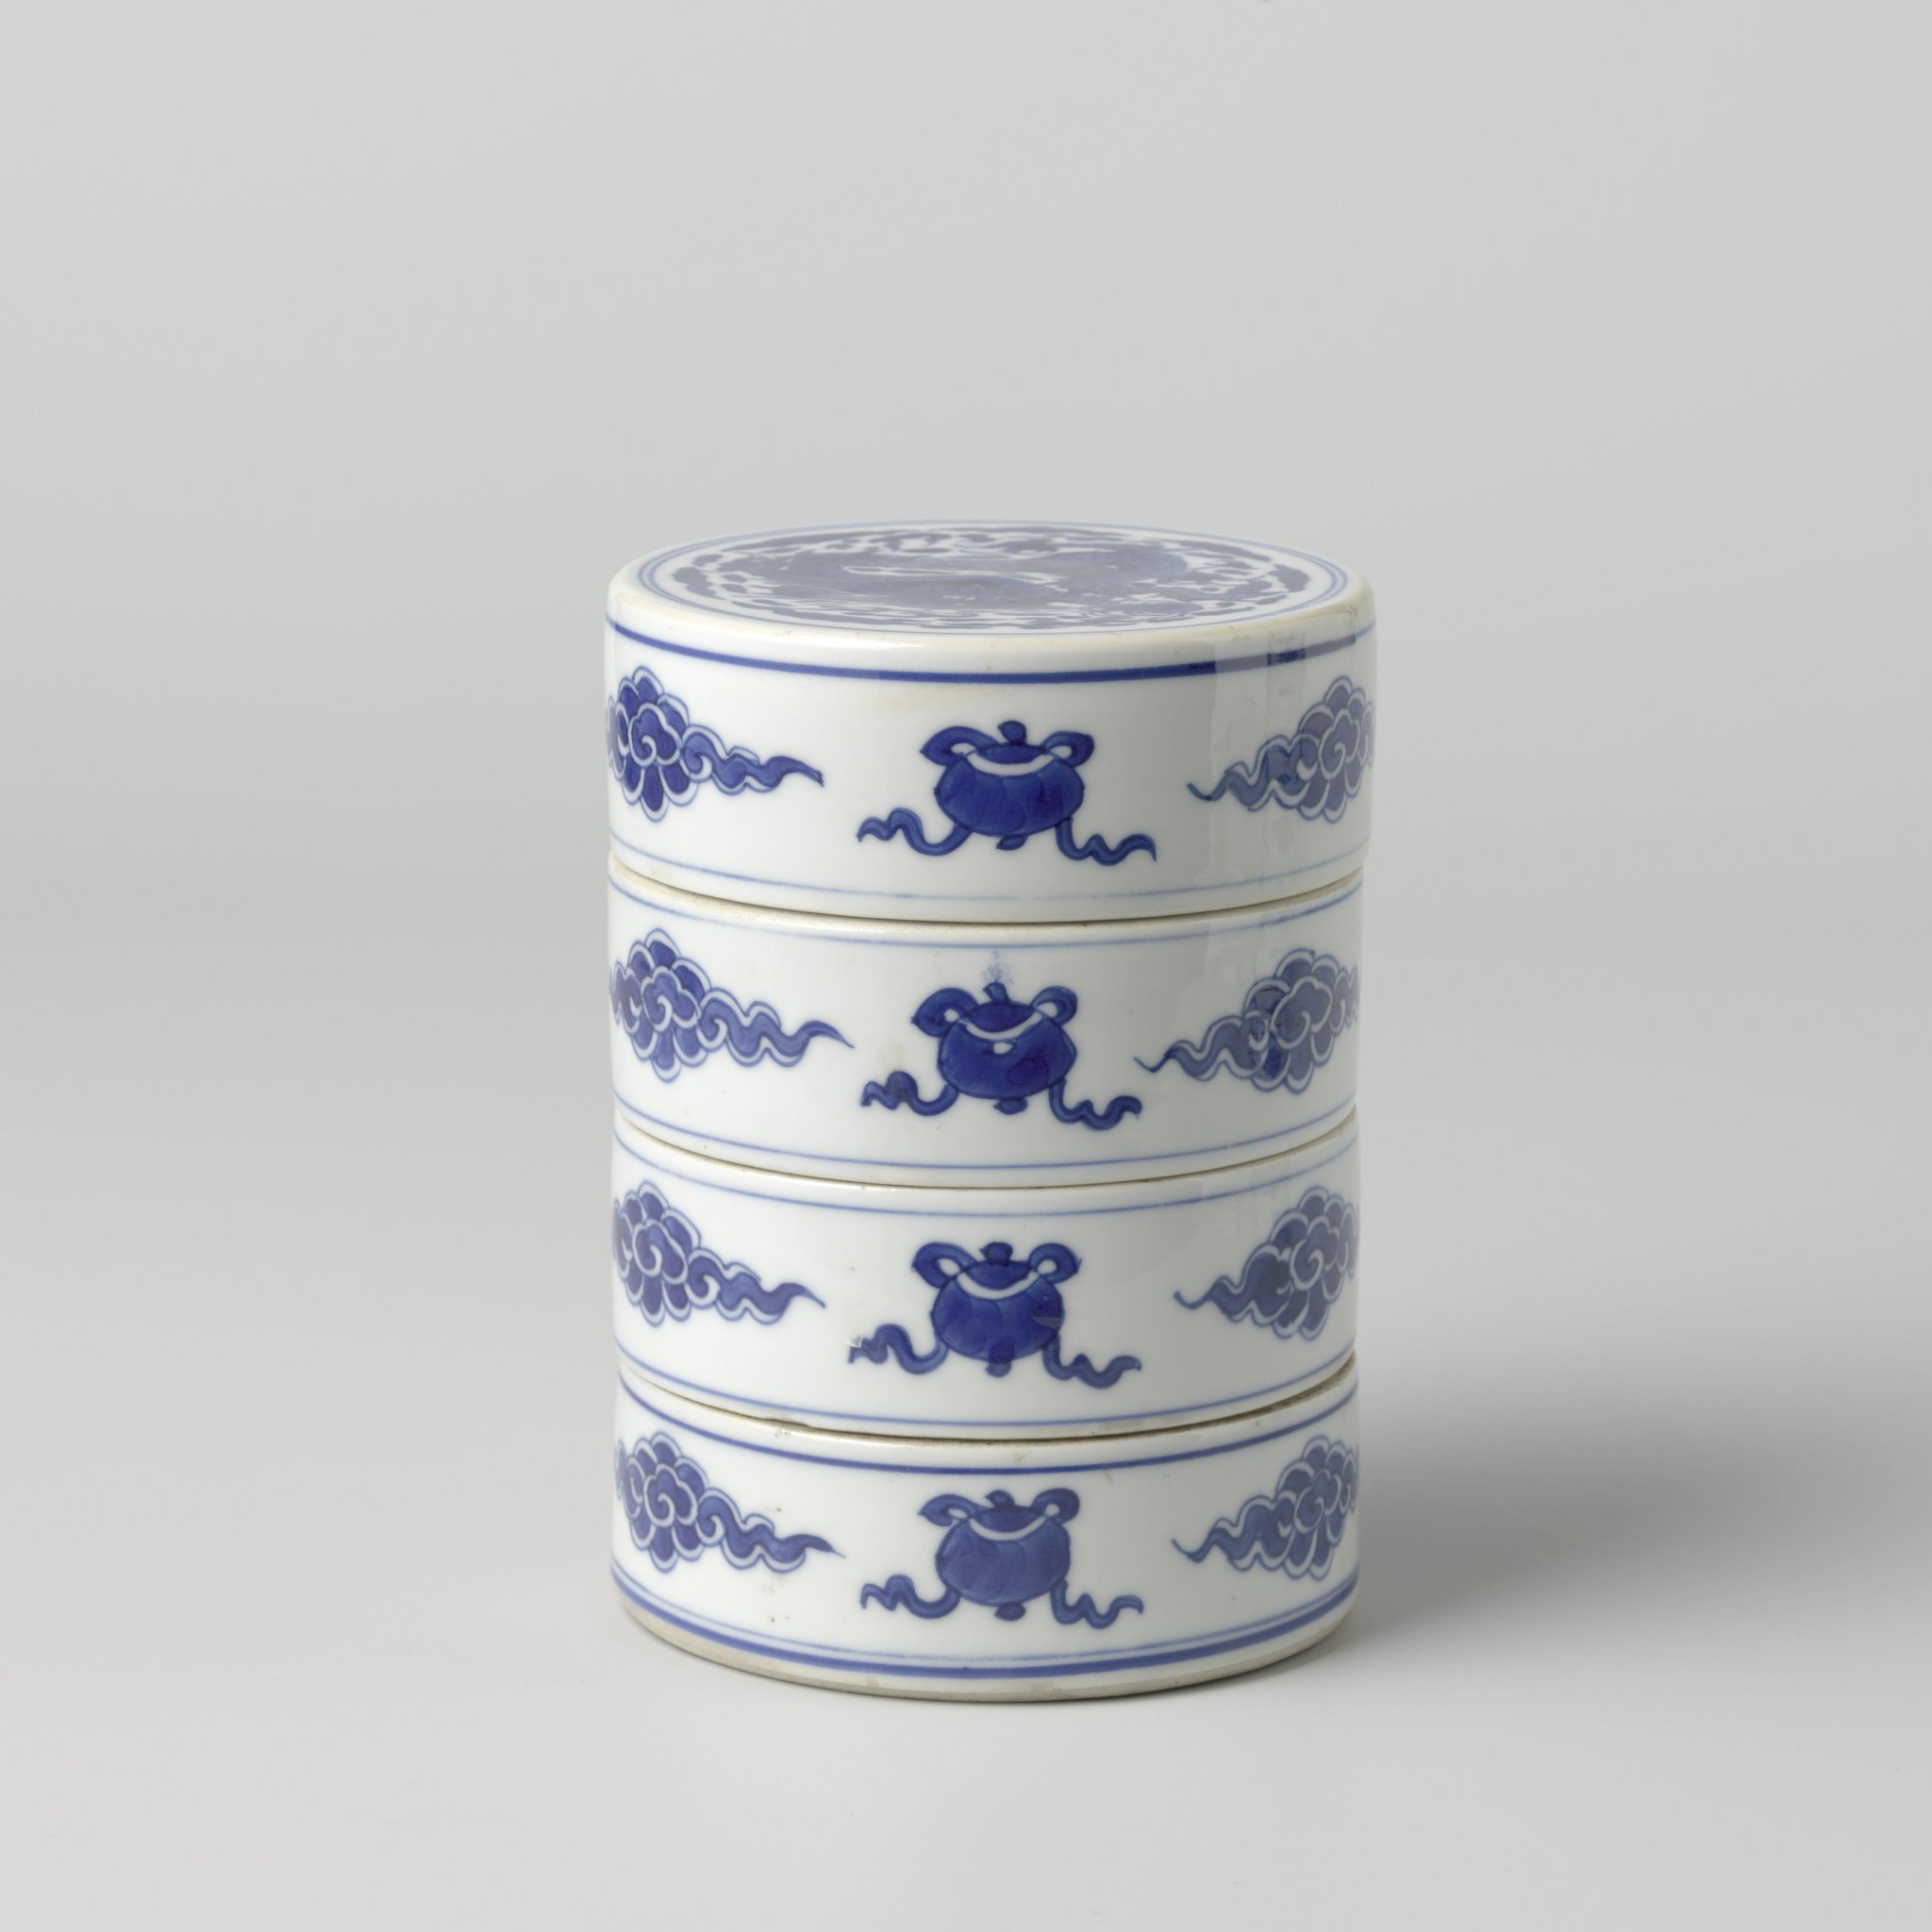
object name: box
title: Tiered box composed of three layers with dragons en precious objects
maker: Anonymous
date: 1680-1720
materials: cobalt, glaze, paint, porcelain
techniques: firing, turning, vitrification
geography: china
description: Ronde stapeldoos van porselein bestaande uit drie lagen en een deksel, beschilderd in onderglazuur blauw. De wanden van de dozen en de deksel met wolkmotieven en kostbaarheden (parel, ruit, muzieksteen). Blauw-wit.